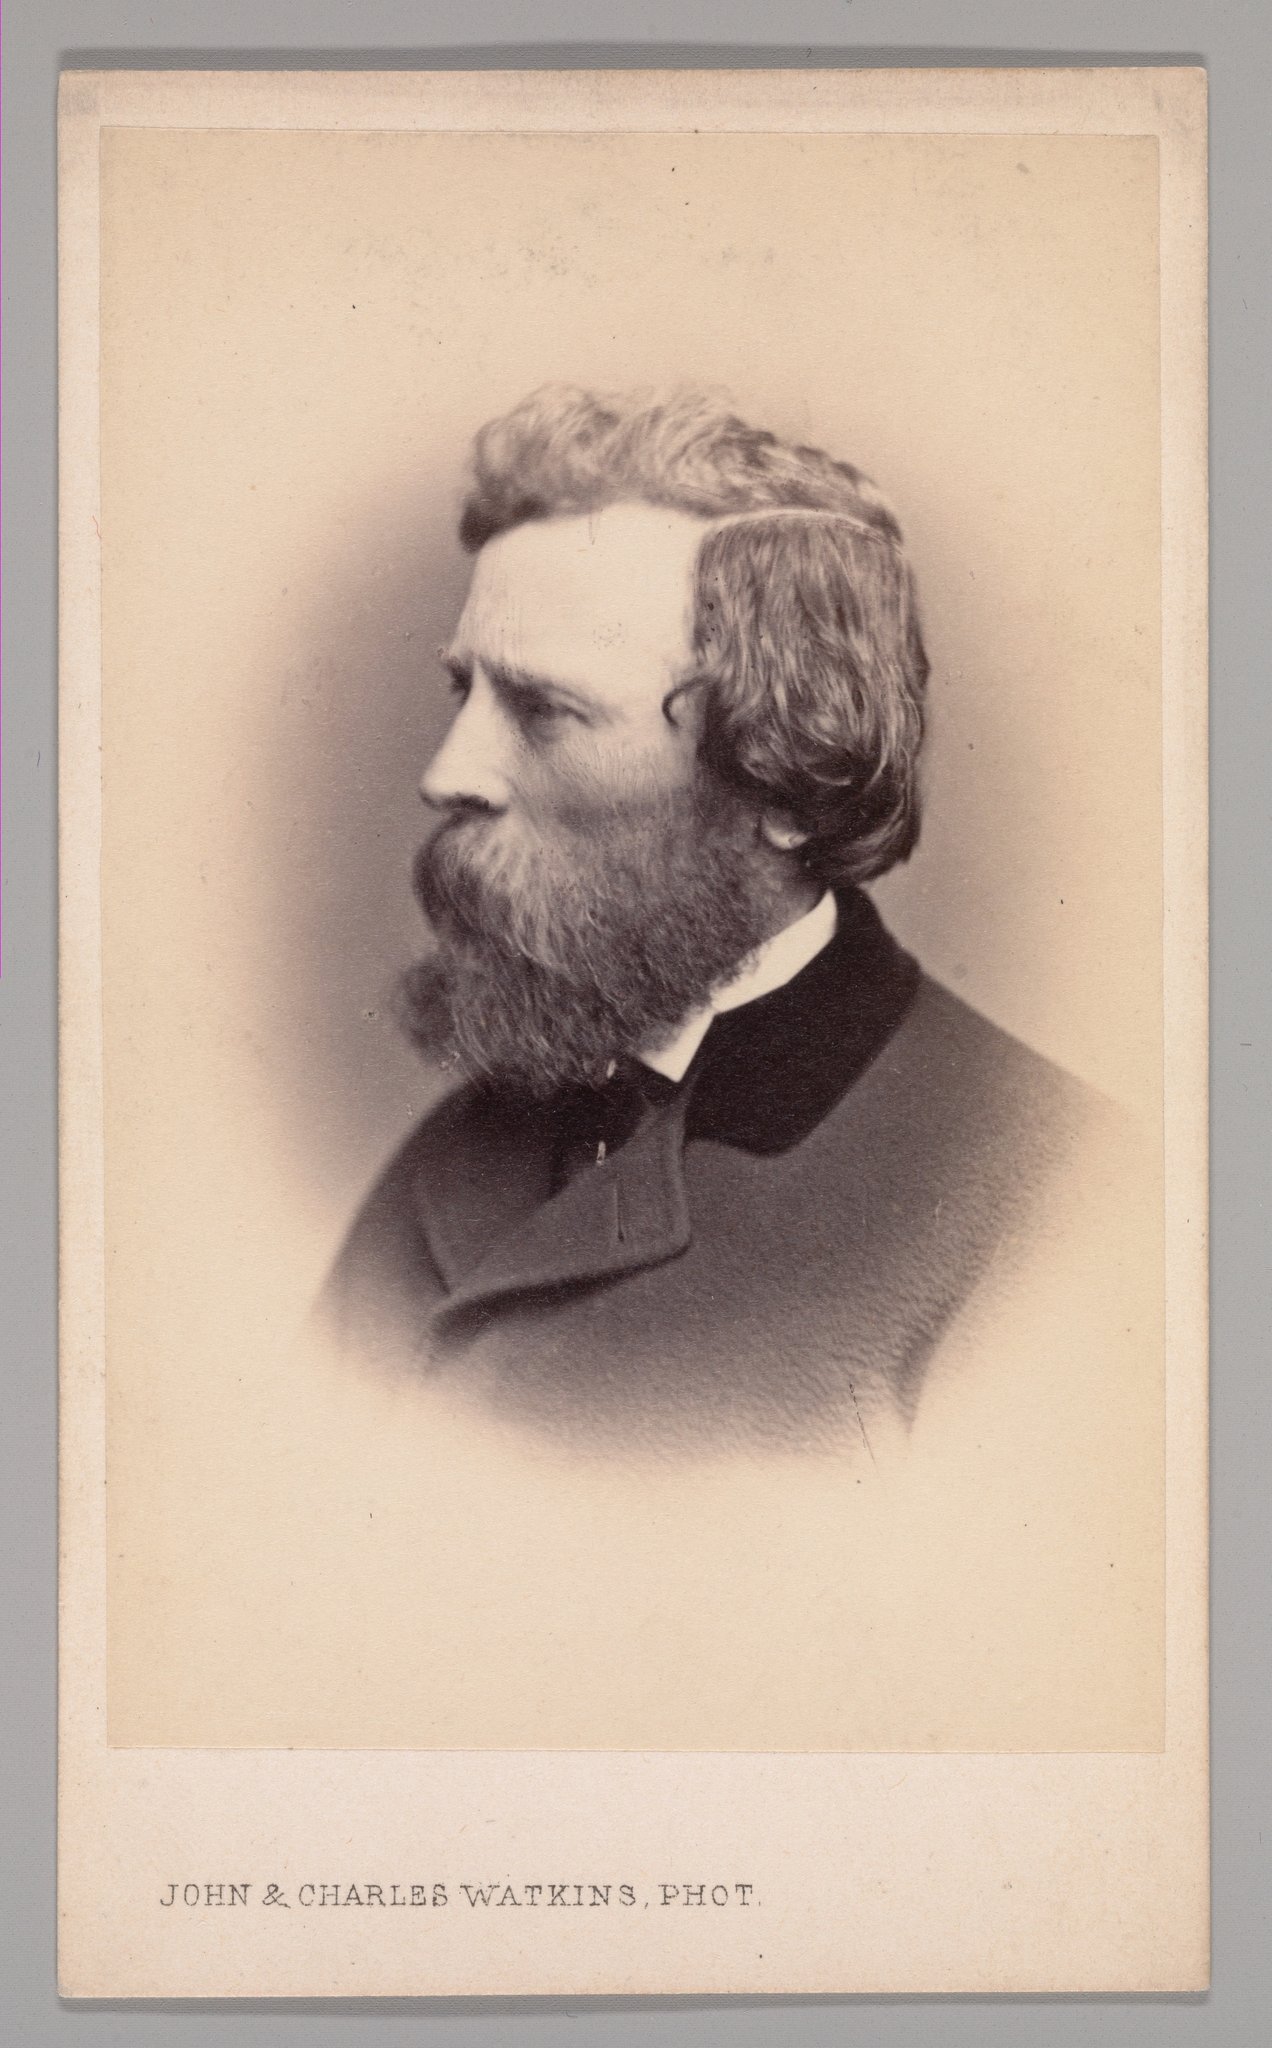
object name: carte de visite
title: [Robert Hannah]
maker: john and charles watkins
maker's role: photography studio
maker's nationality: british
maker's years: 1840-1875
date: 1860-1869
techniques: albumen silver print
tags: men,portraits,profiles